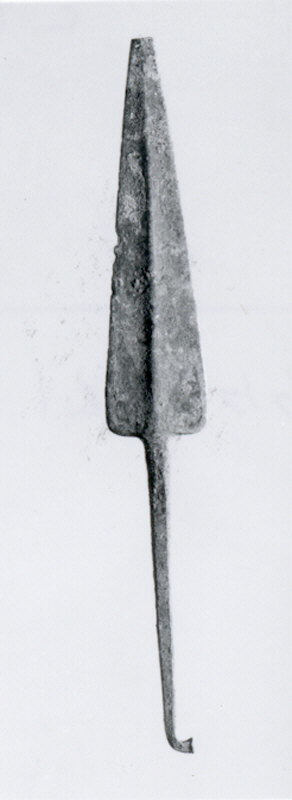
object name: spearhead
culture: iranian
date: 1333-668 BCE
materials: bronze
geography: northwestern iran, caspian region